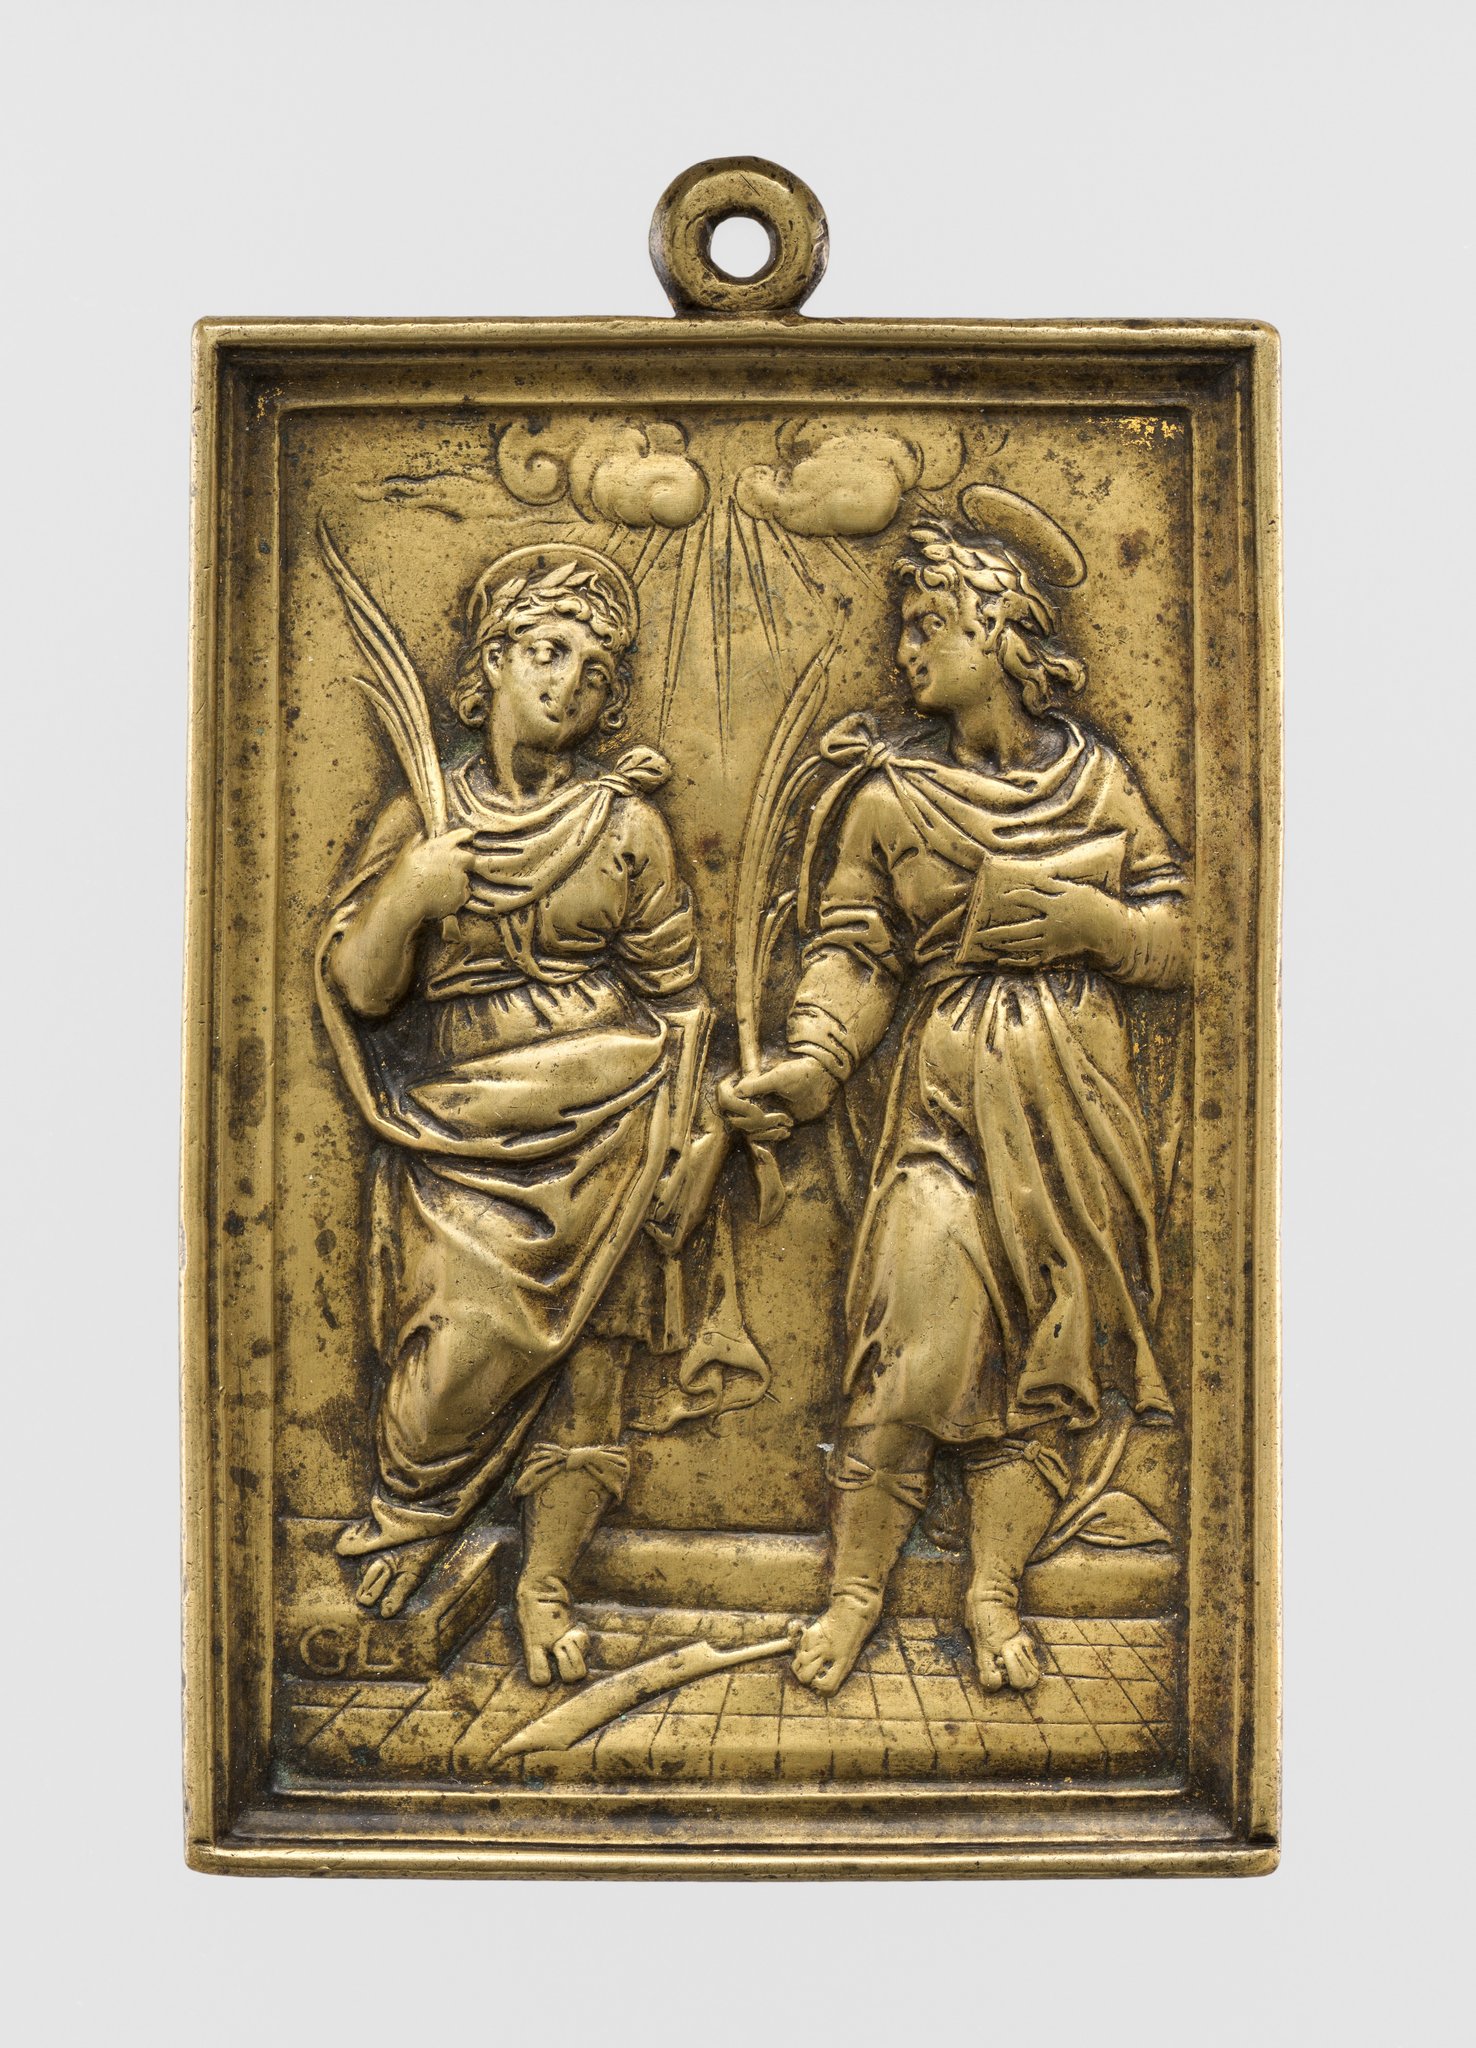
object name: plaquette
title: Saints Acisclus and Victoria (?)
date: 1601-1633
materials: bronze, patina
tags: saints